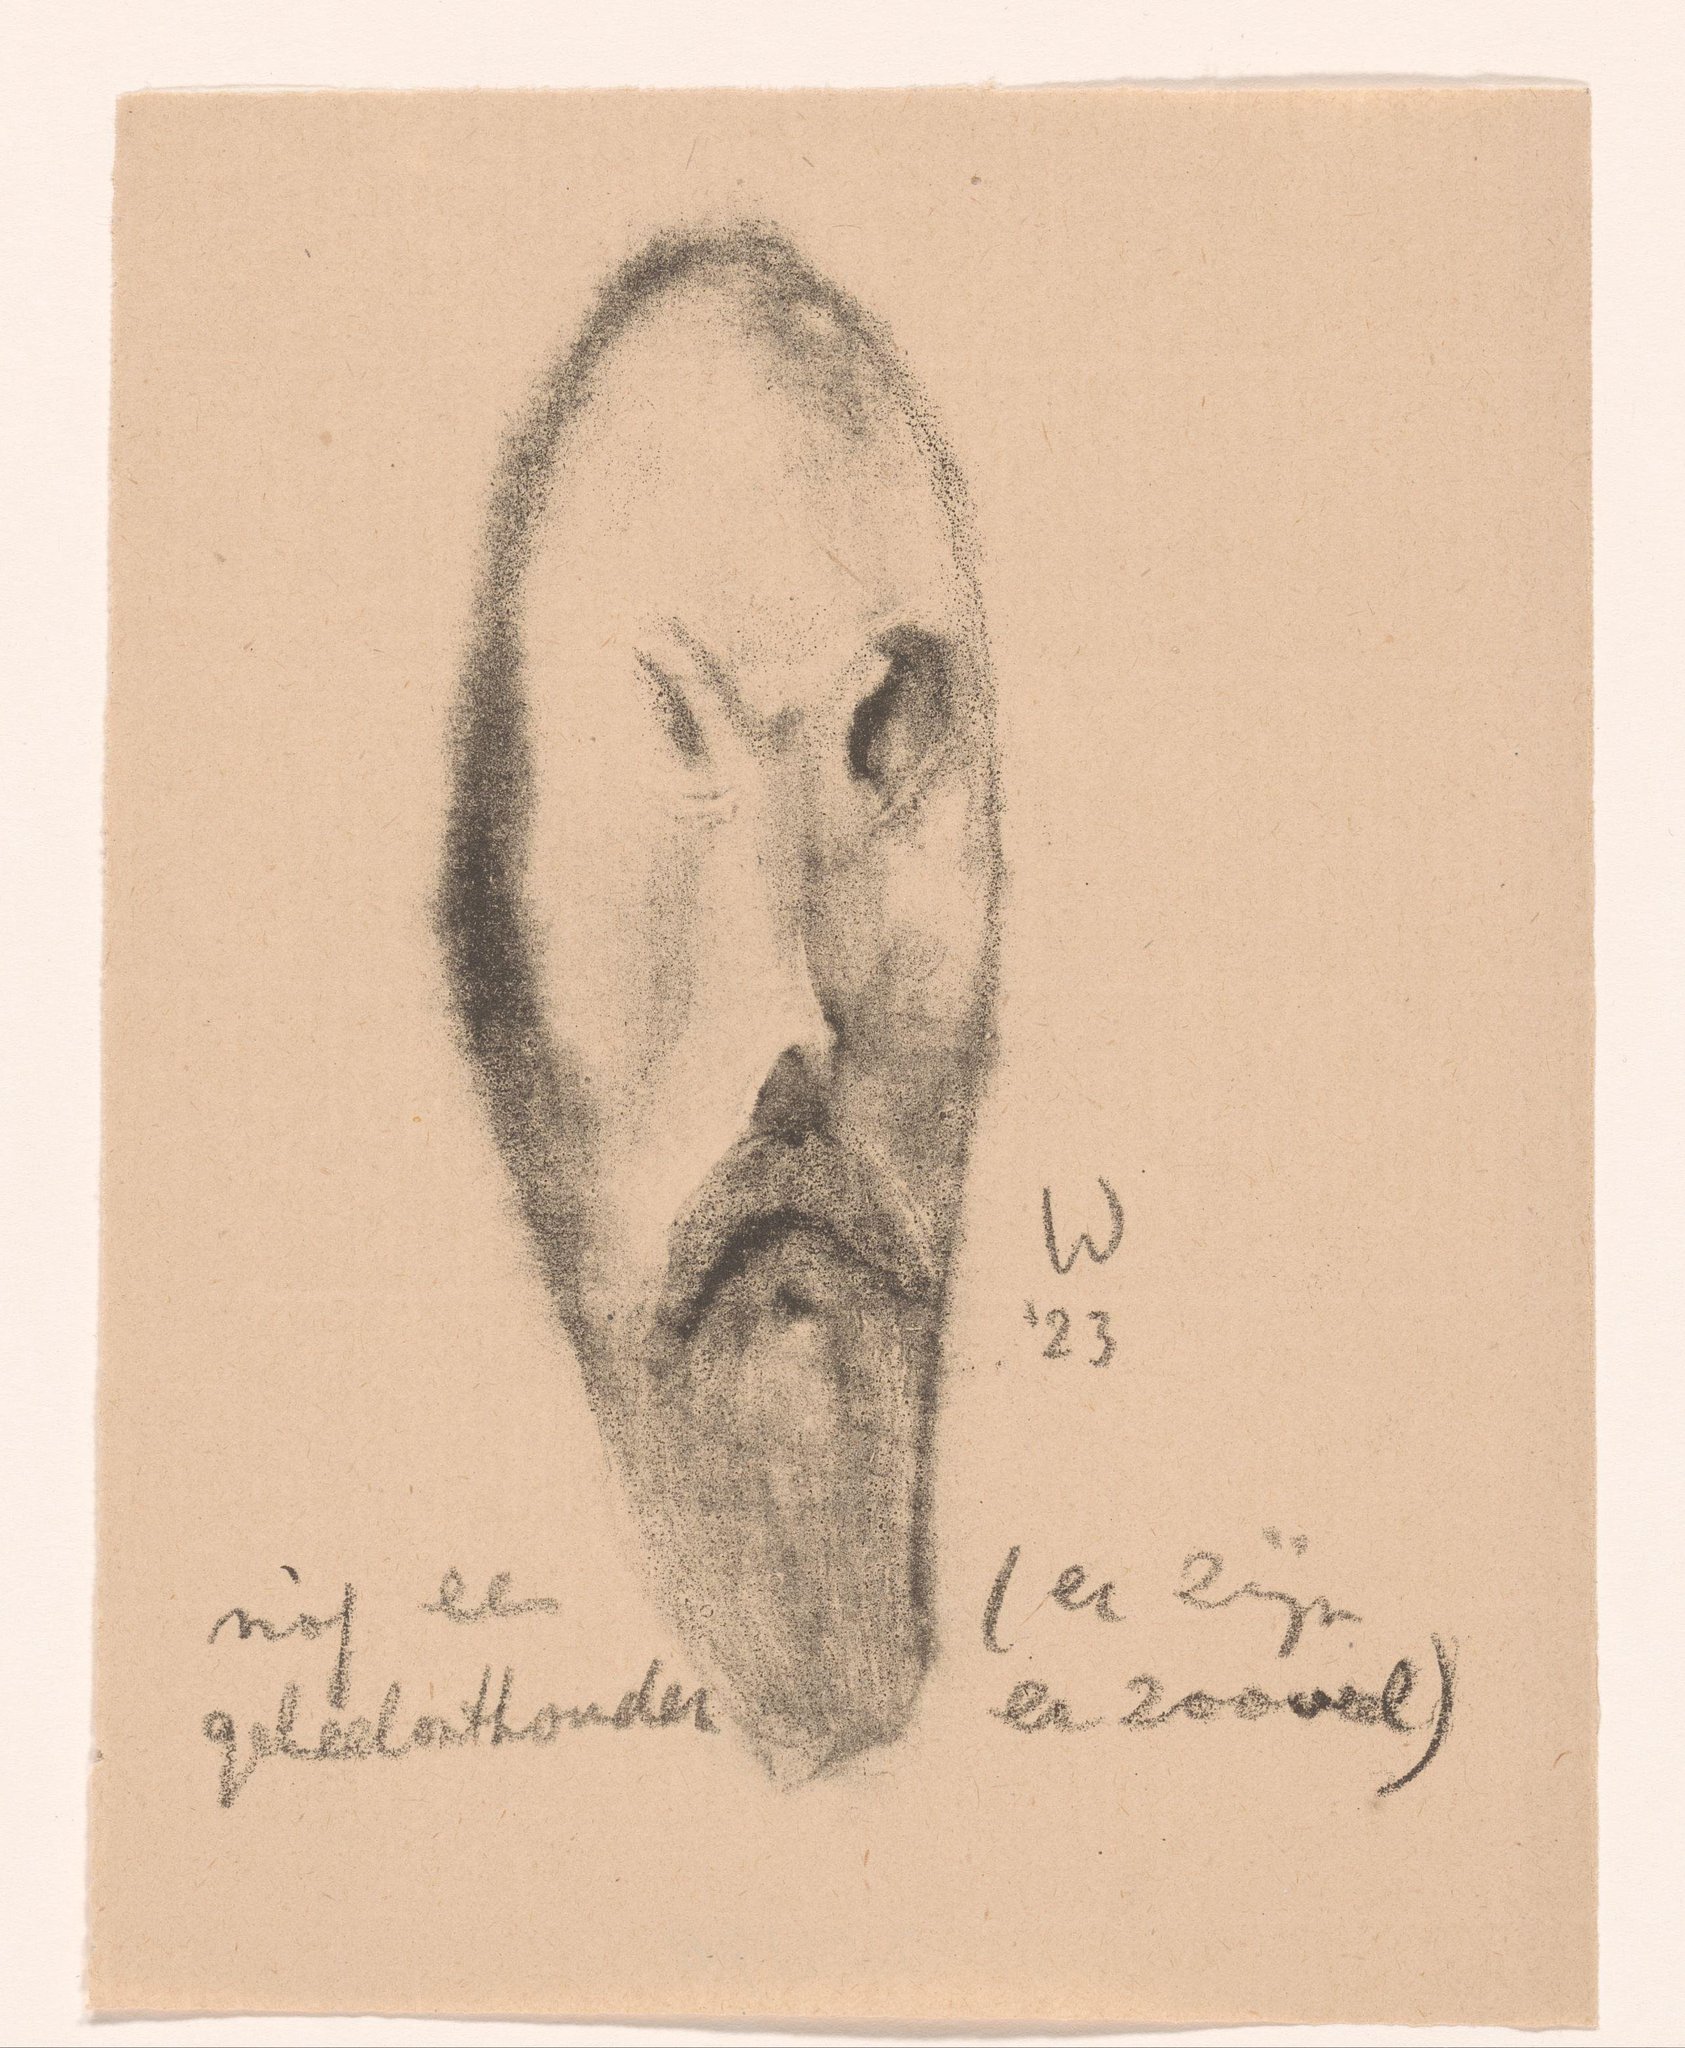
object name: print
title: Idealisten II en verdere Kanttekeningen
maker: erich wichmann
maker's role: print maker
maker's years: 1890-1929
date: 1923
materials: paper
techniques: lithograph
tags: caricatures (human types)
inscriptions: collector's mark: Lugt 2228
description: Onderaan de tekst: 'nòg een geheelonthouder (er zijn er zooveel)'.